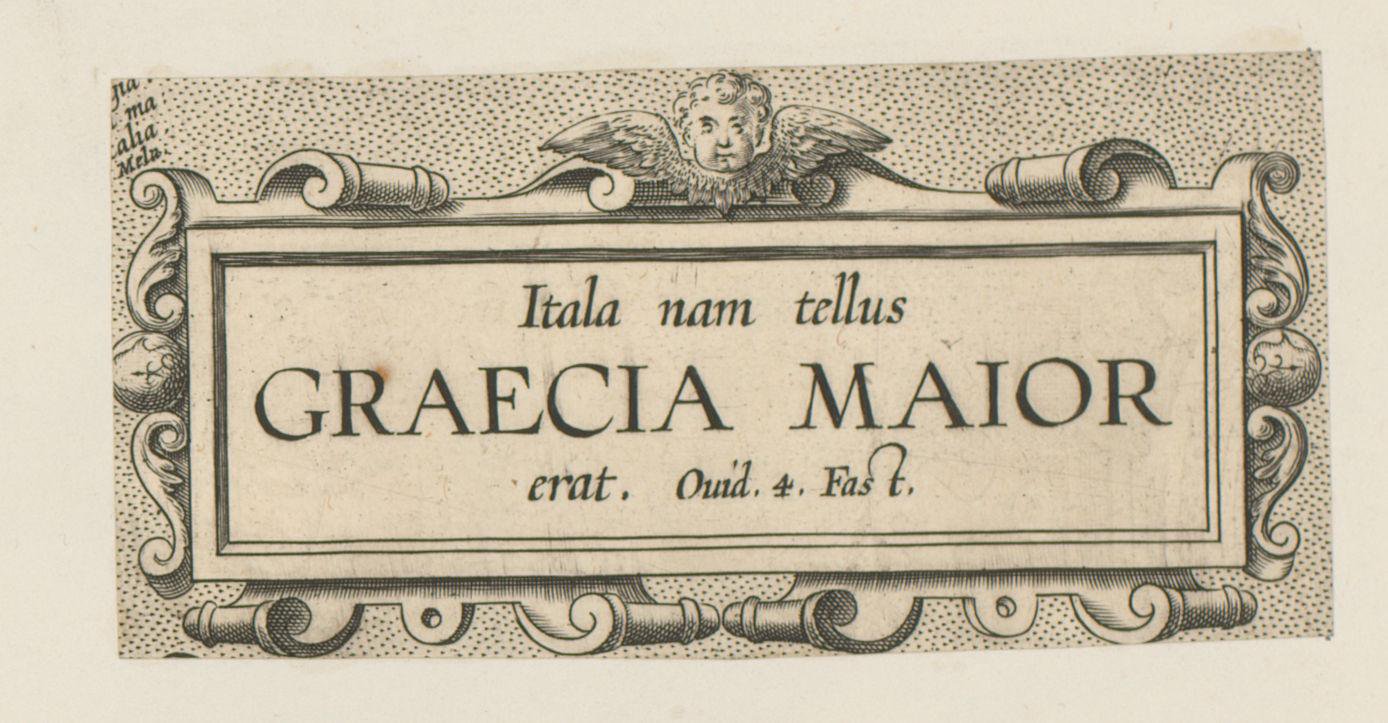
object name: ornament print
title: Rechthoekige cartouche met rolwerk en cherubijn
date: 1595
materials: paper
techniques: engraving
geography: antwerp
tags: cherubs, i.e. children's heads with wings, scrollwork, strapwork ~ ornament, ornament ~ cartouche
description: Rechthoekige cartouche met rolwerk en midden boven een cherubijn. De cartouche is een fragment van een kaart van Zuid-Italië. De prent maakt deel uit van een album.